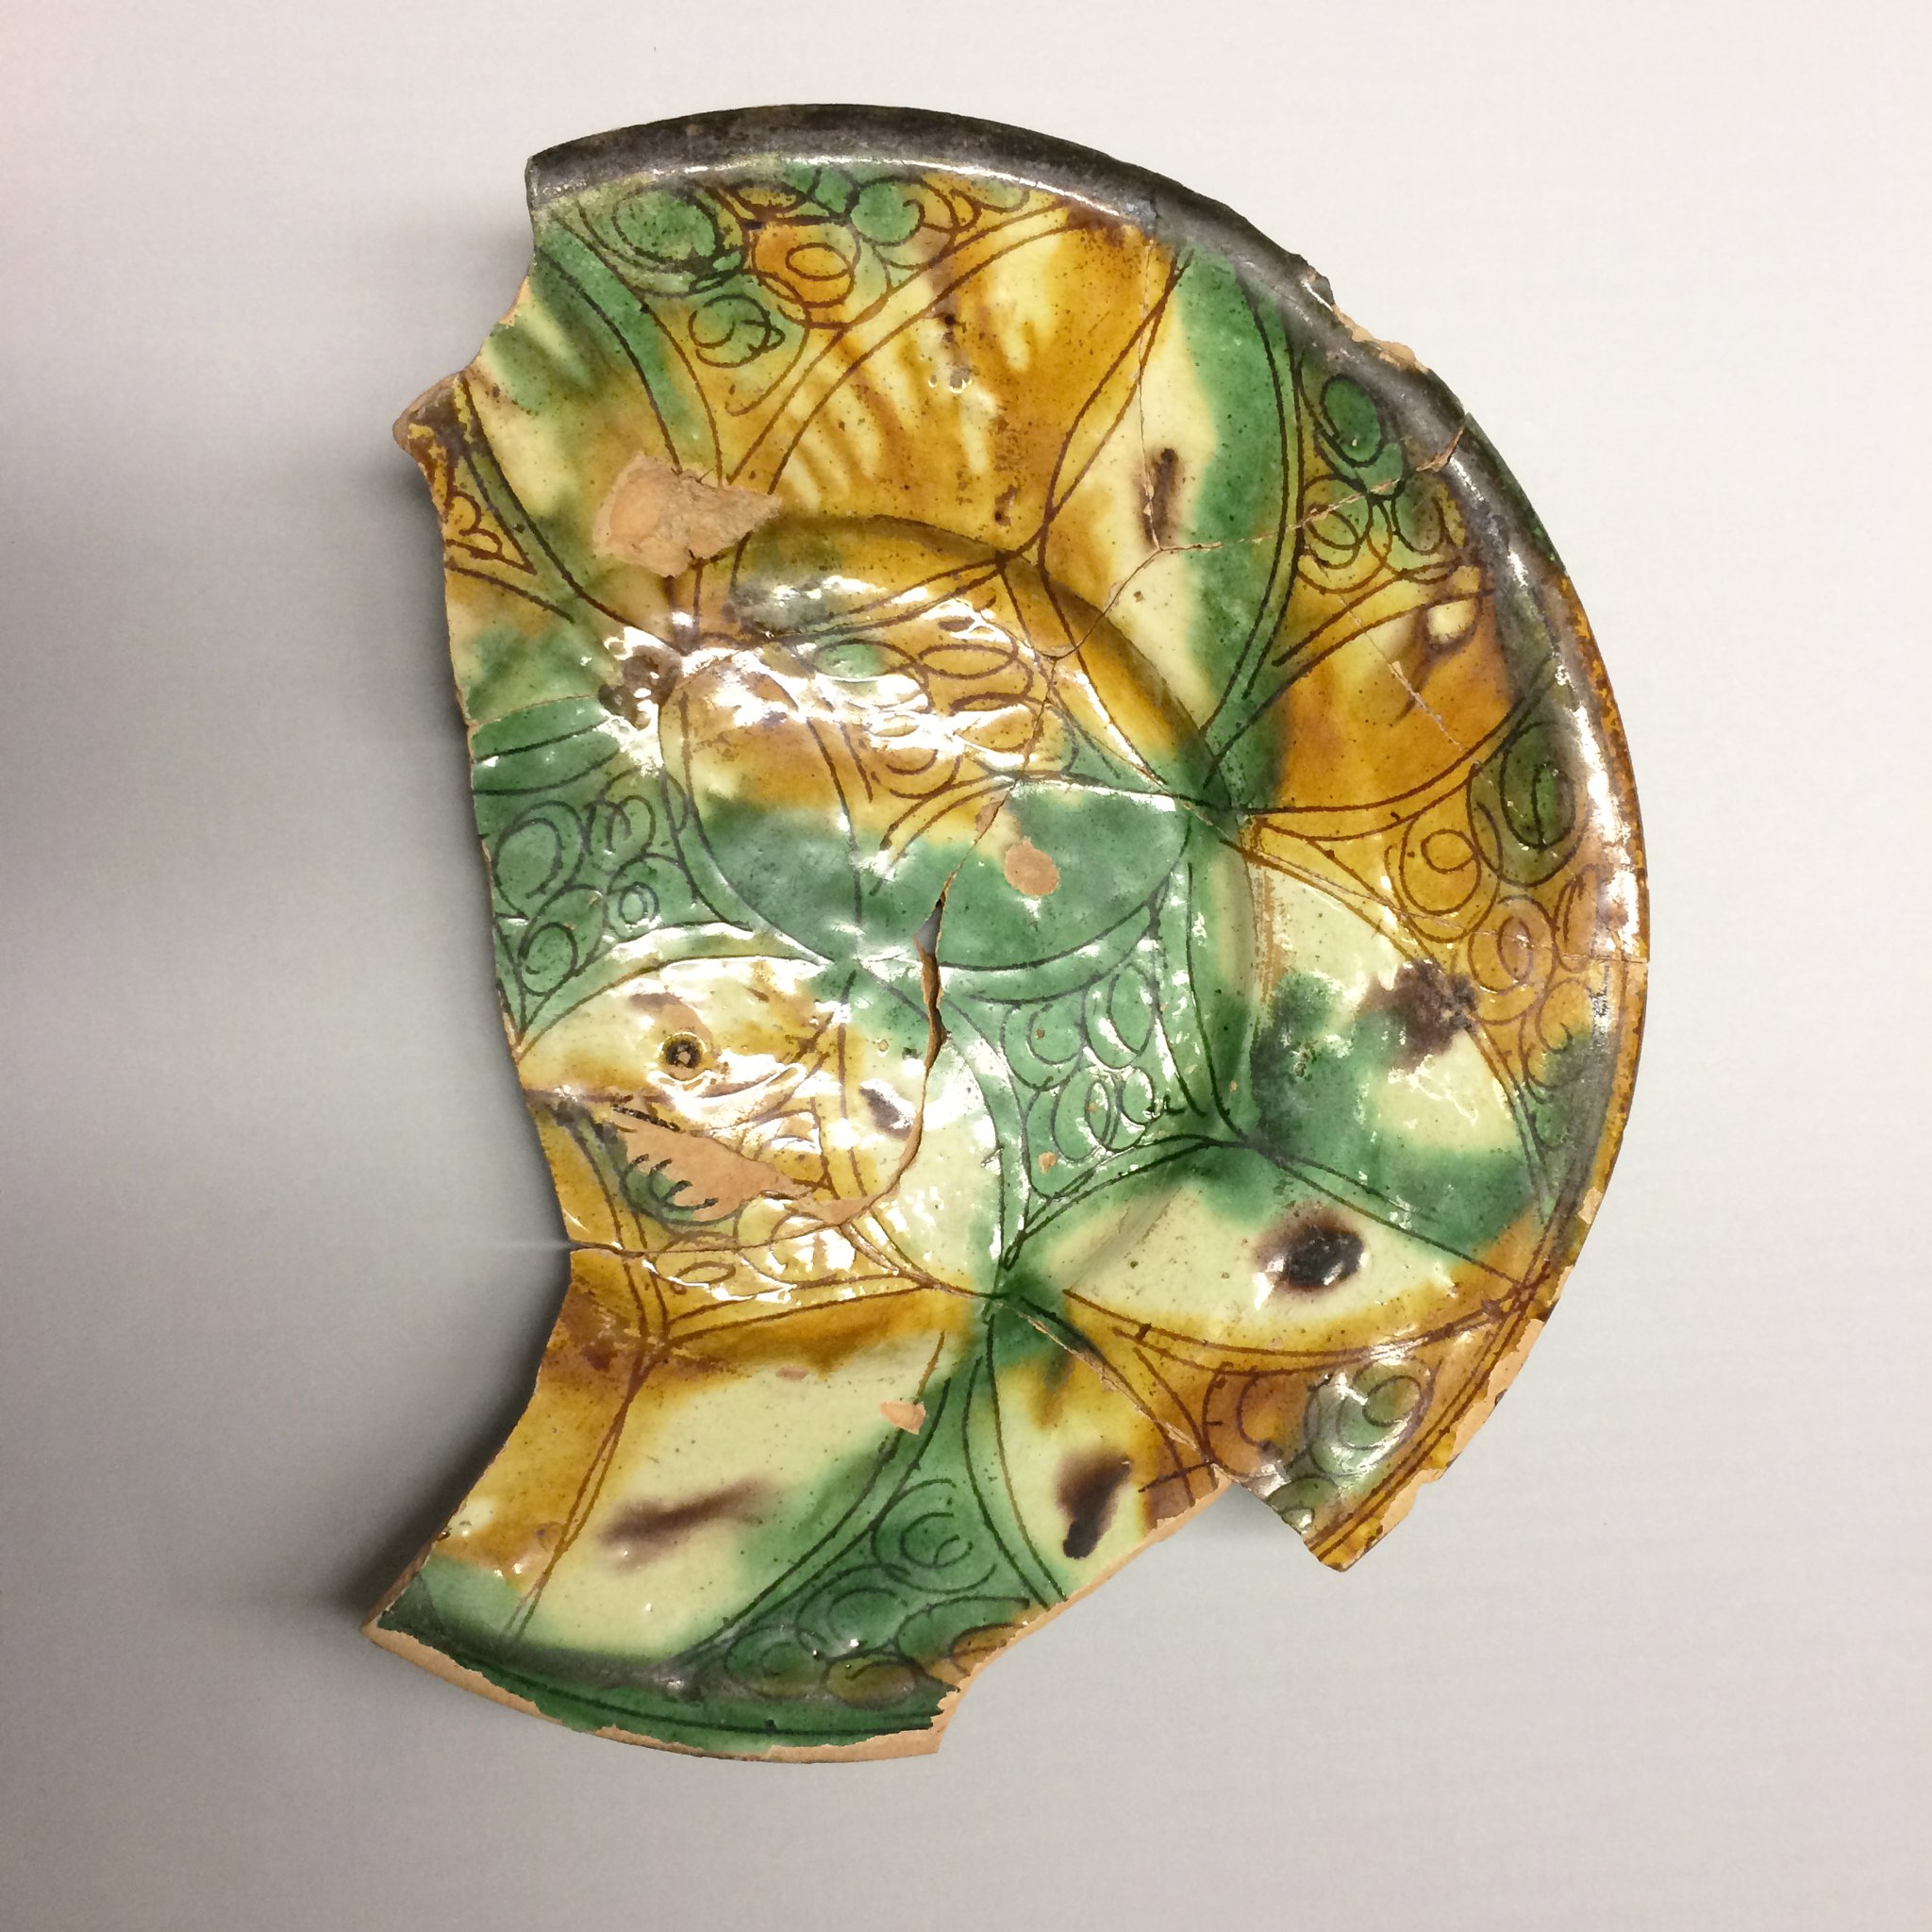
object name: plate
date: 901-1100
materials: earthenware, glaze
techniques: incising, polychrome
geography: iran